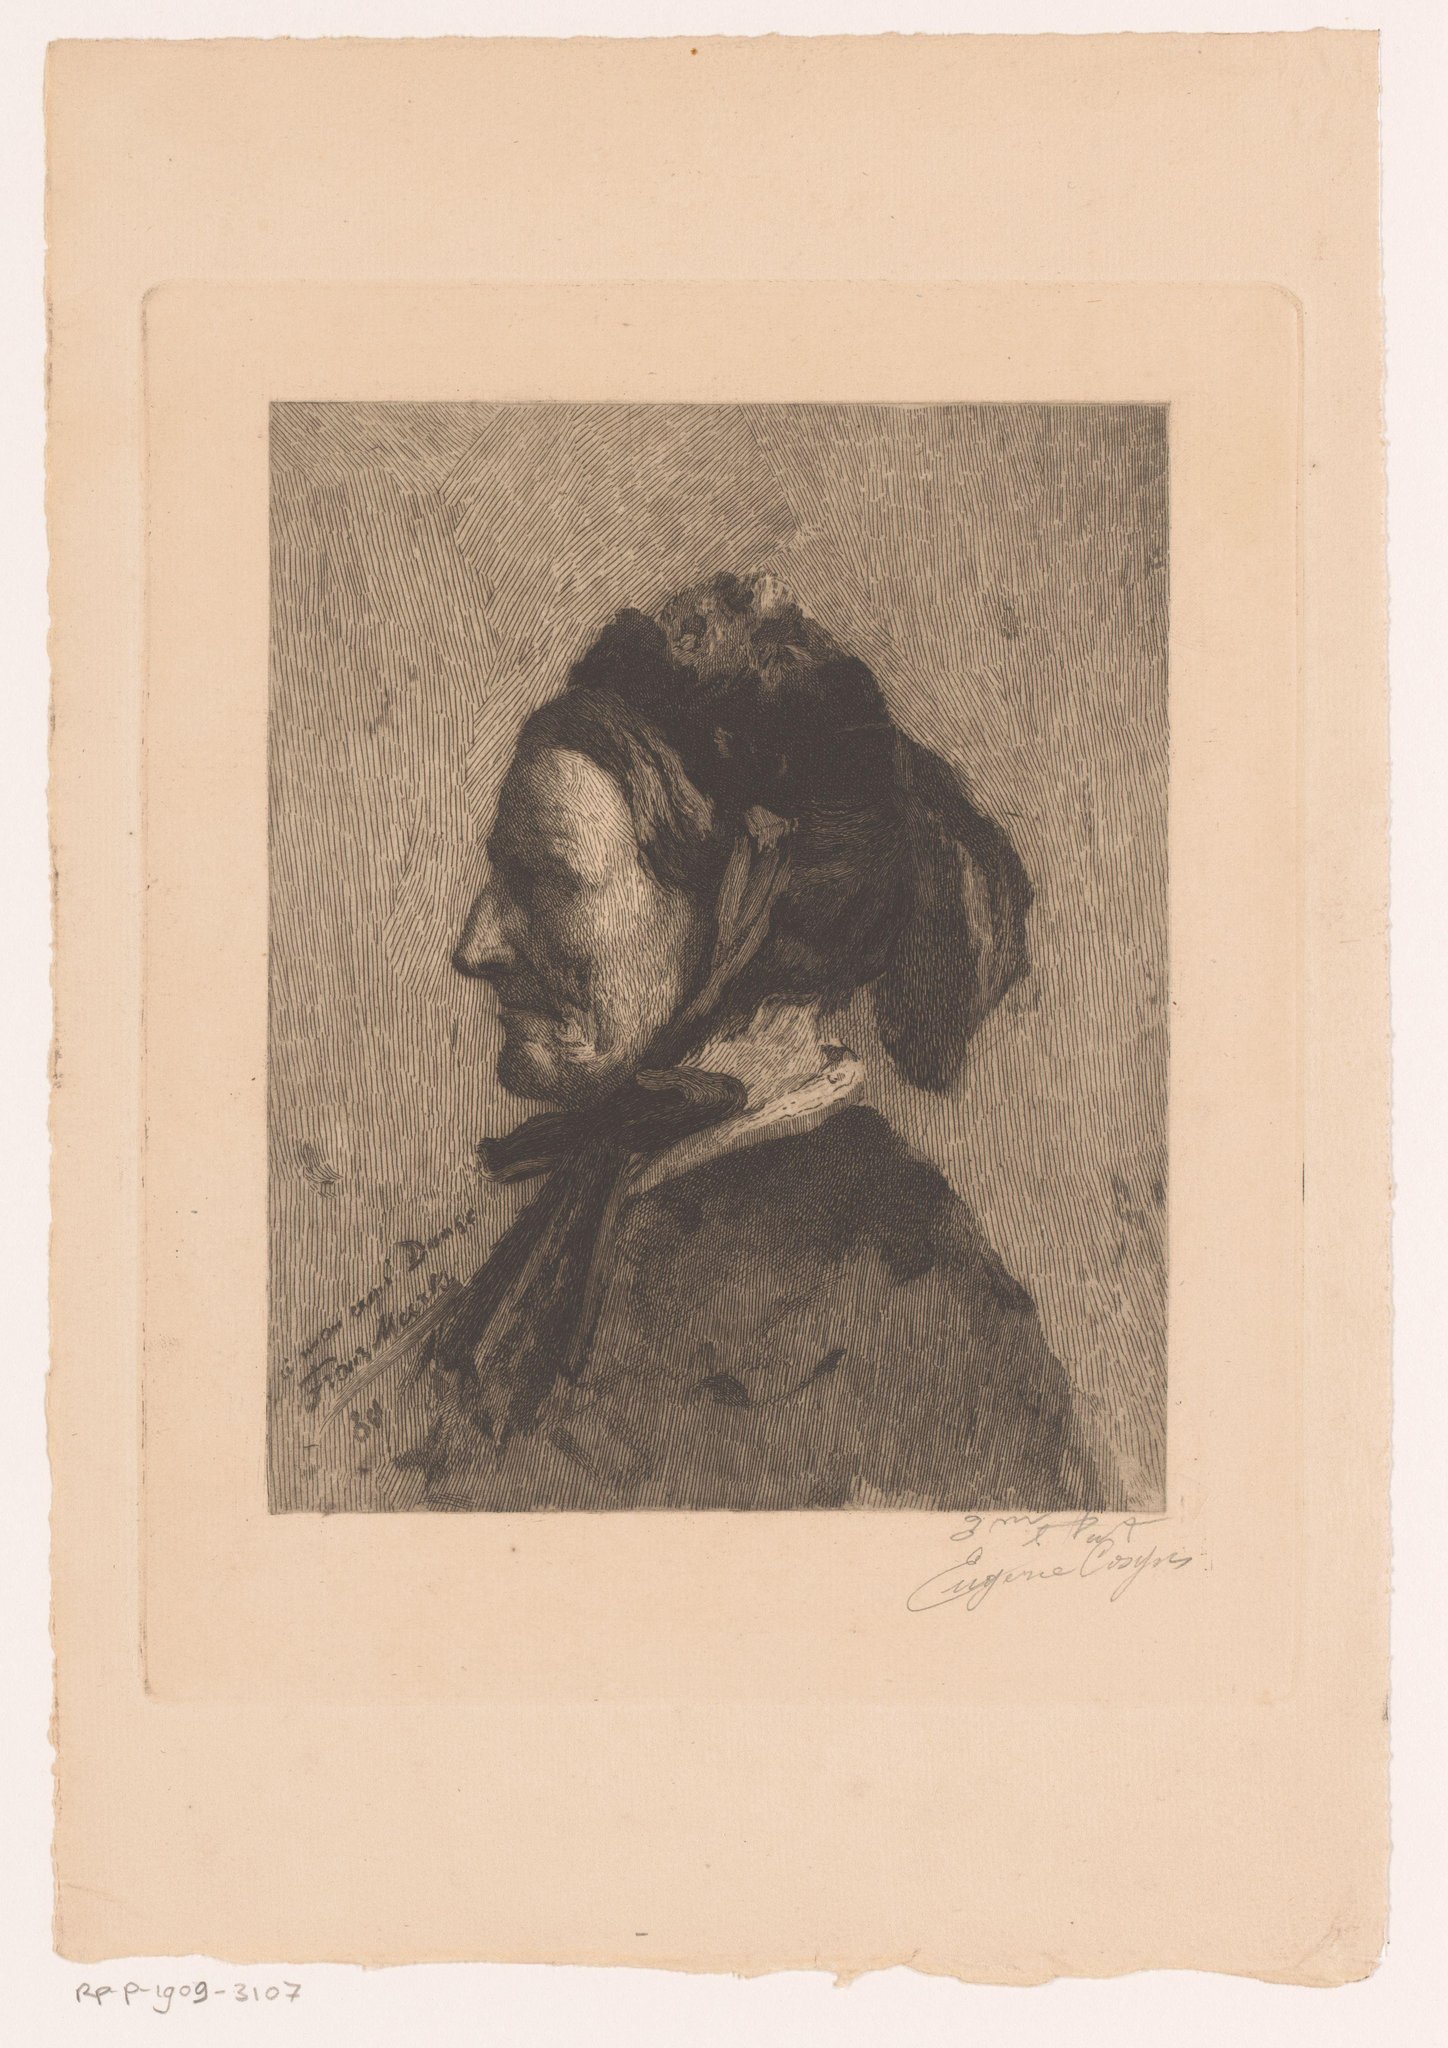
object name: print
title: Portret van een onbekende oude vrouw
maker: eugène cosyns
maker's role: print maker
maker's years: 1862-1909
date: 1880-1909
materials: paper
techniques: etching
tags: historical persons, old woman (+ sideview, profile)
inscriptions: collector's mark: Lugt 2228, inscription: ‘3 m etat’